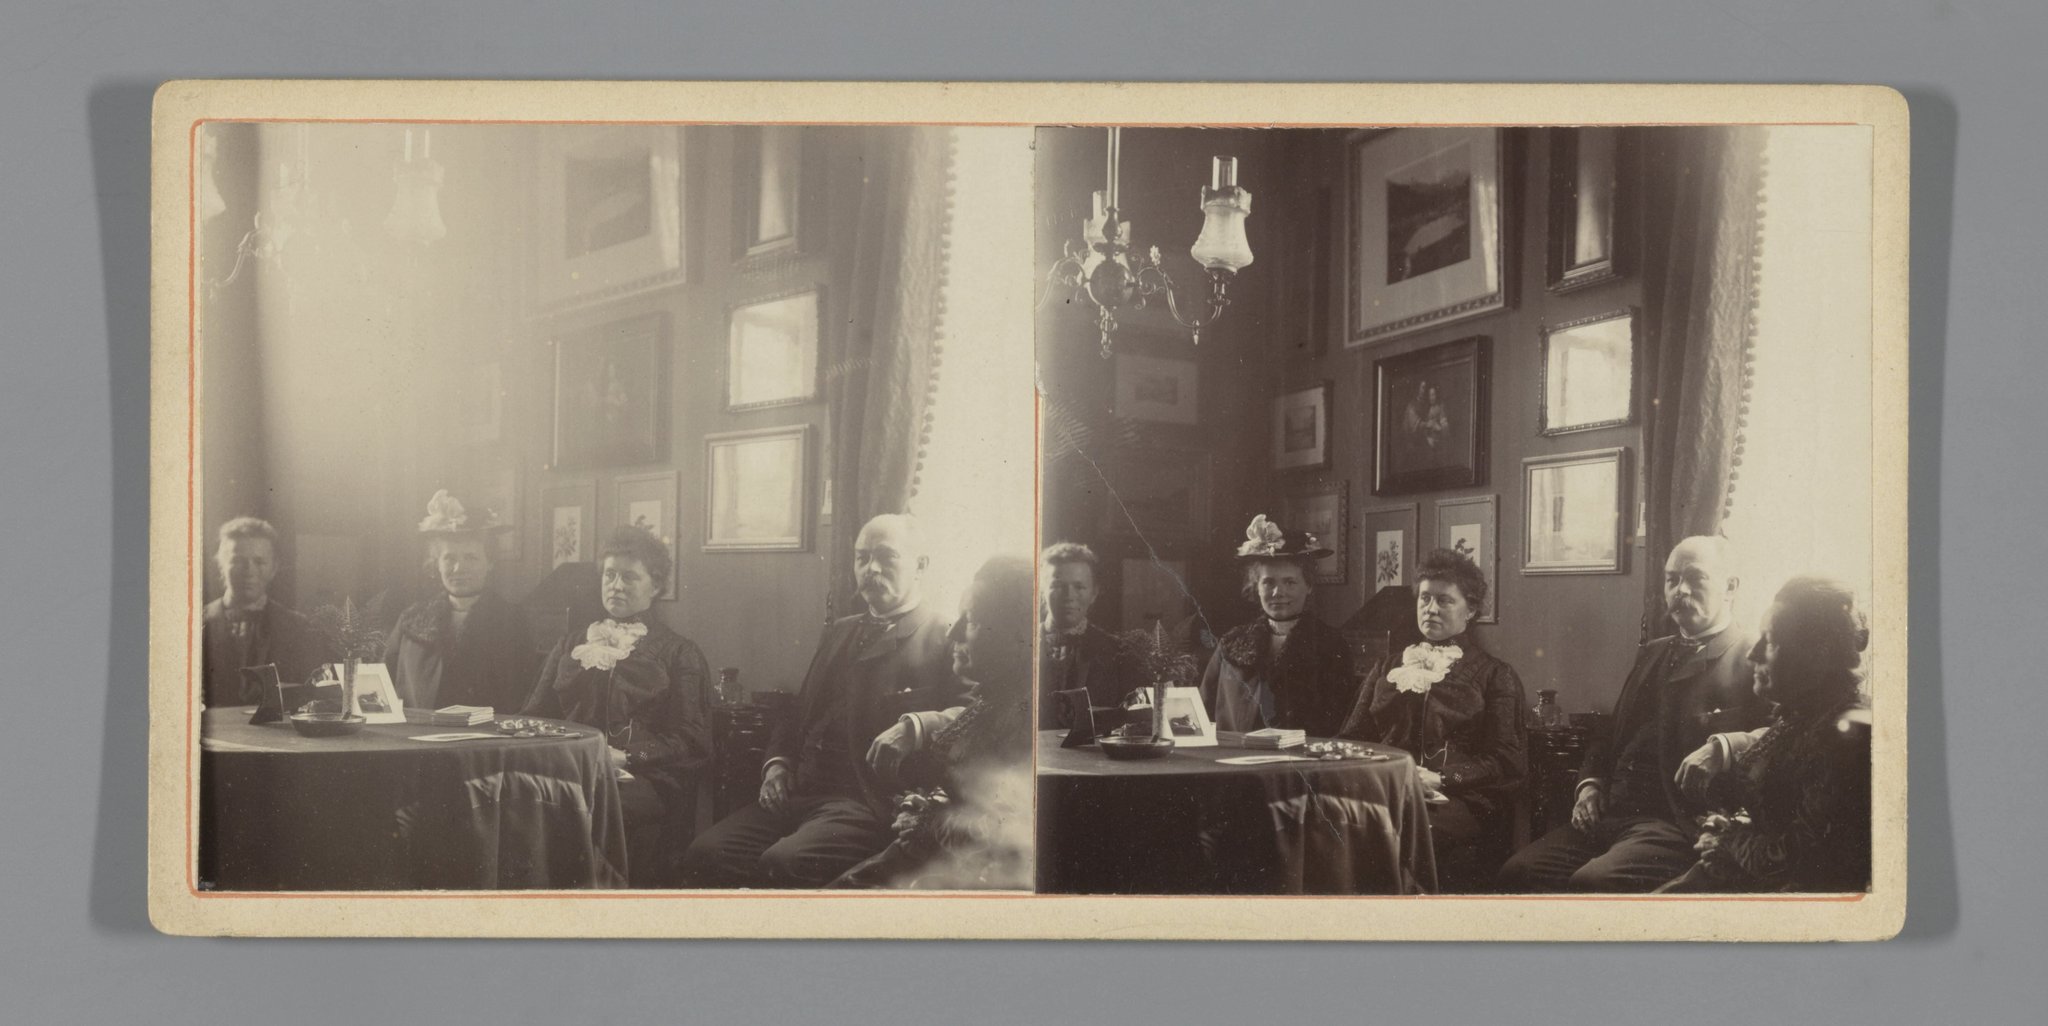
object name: stereograph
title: Groepsportret in huiskamer met op tafel stereoscoop en foto's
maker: theo van heemstede obelt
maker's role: amateurfotograaf, architect, directeur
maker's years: 1857-1918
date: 1890-1920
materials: cardboard, photographic support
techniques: gelatin silver print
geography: amsterdam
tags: photograph, stereoscope, family life at home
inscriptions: workshop stamp: ‘Th. van Heemstede Obelt / Amat. Fot. / Amsterdam’